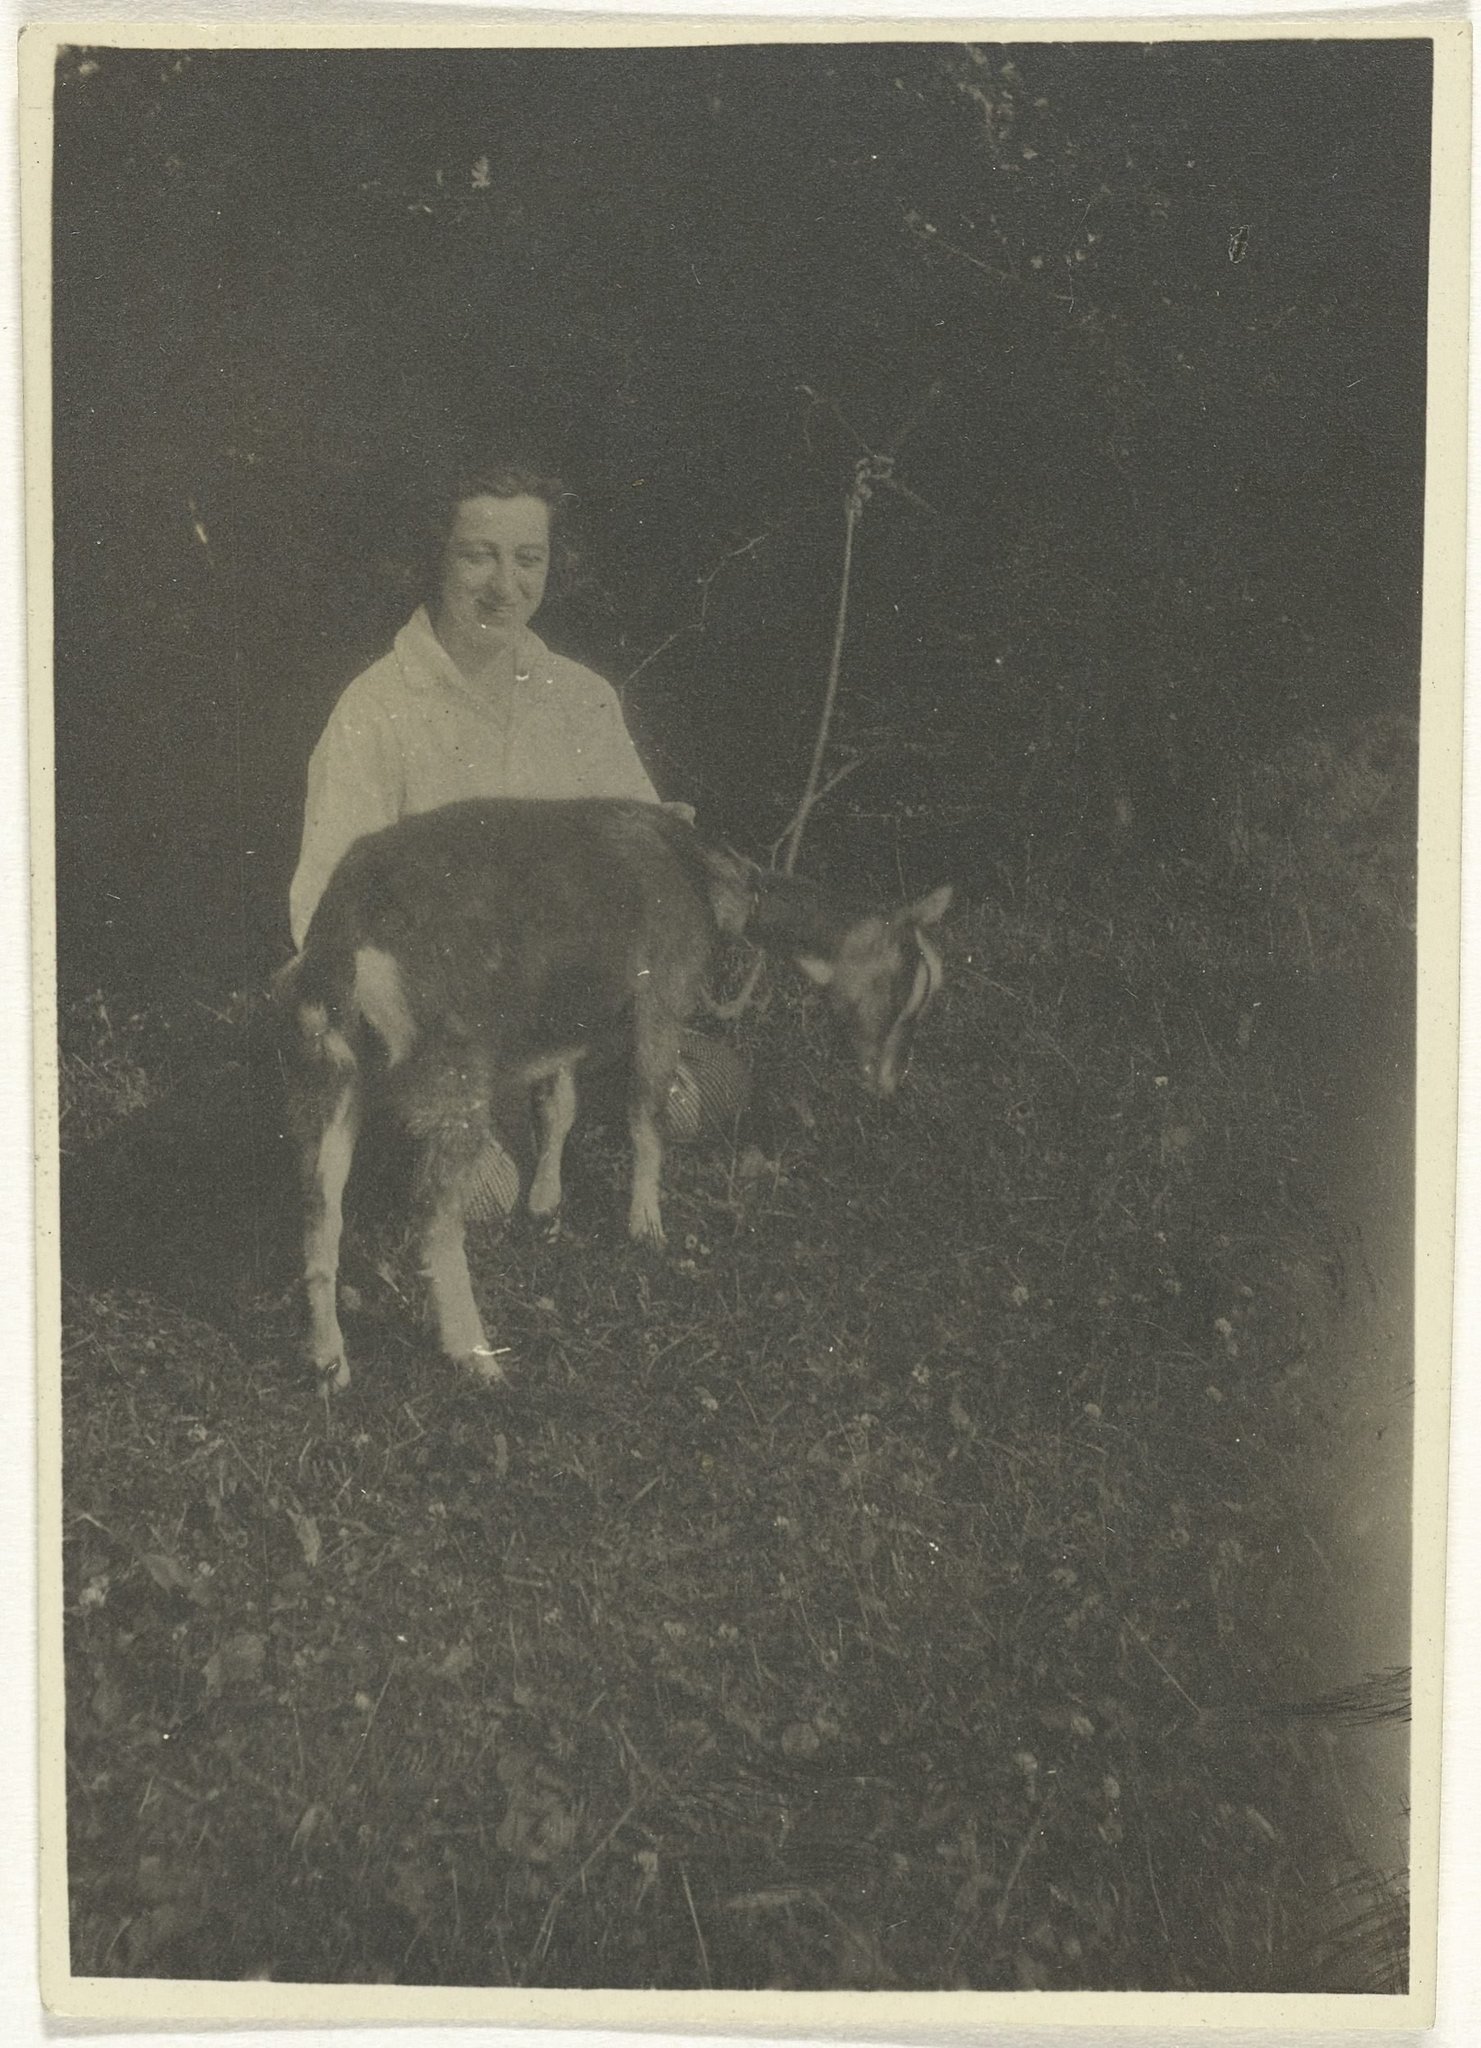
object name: photograph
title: Portret van Irene With met geit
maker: Anonymous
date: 1920-1935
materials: paper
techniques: gelatin silver print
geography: germany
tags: amsterdam, adult woman, historical persons, goat, germany